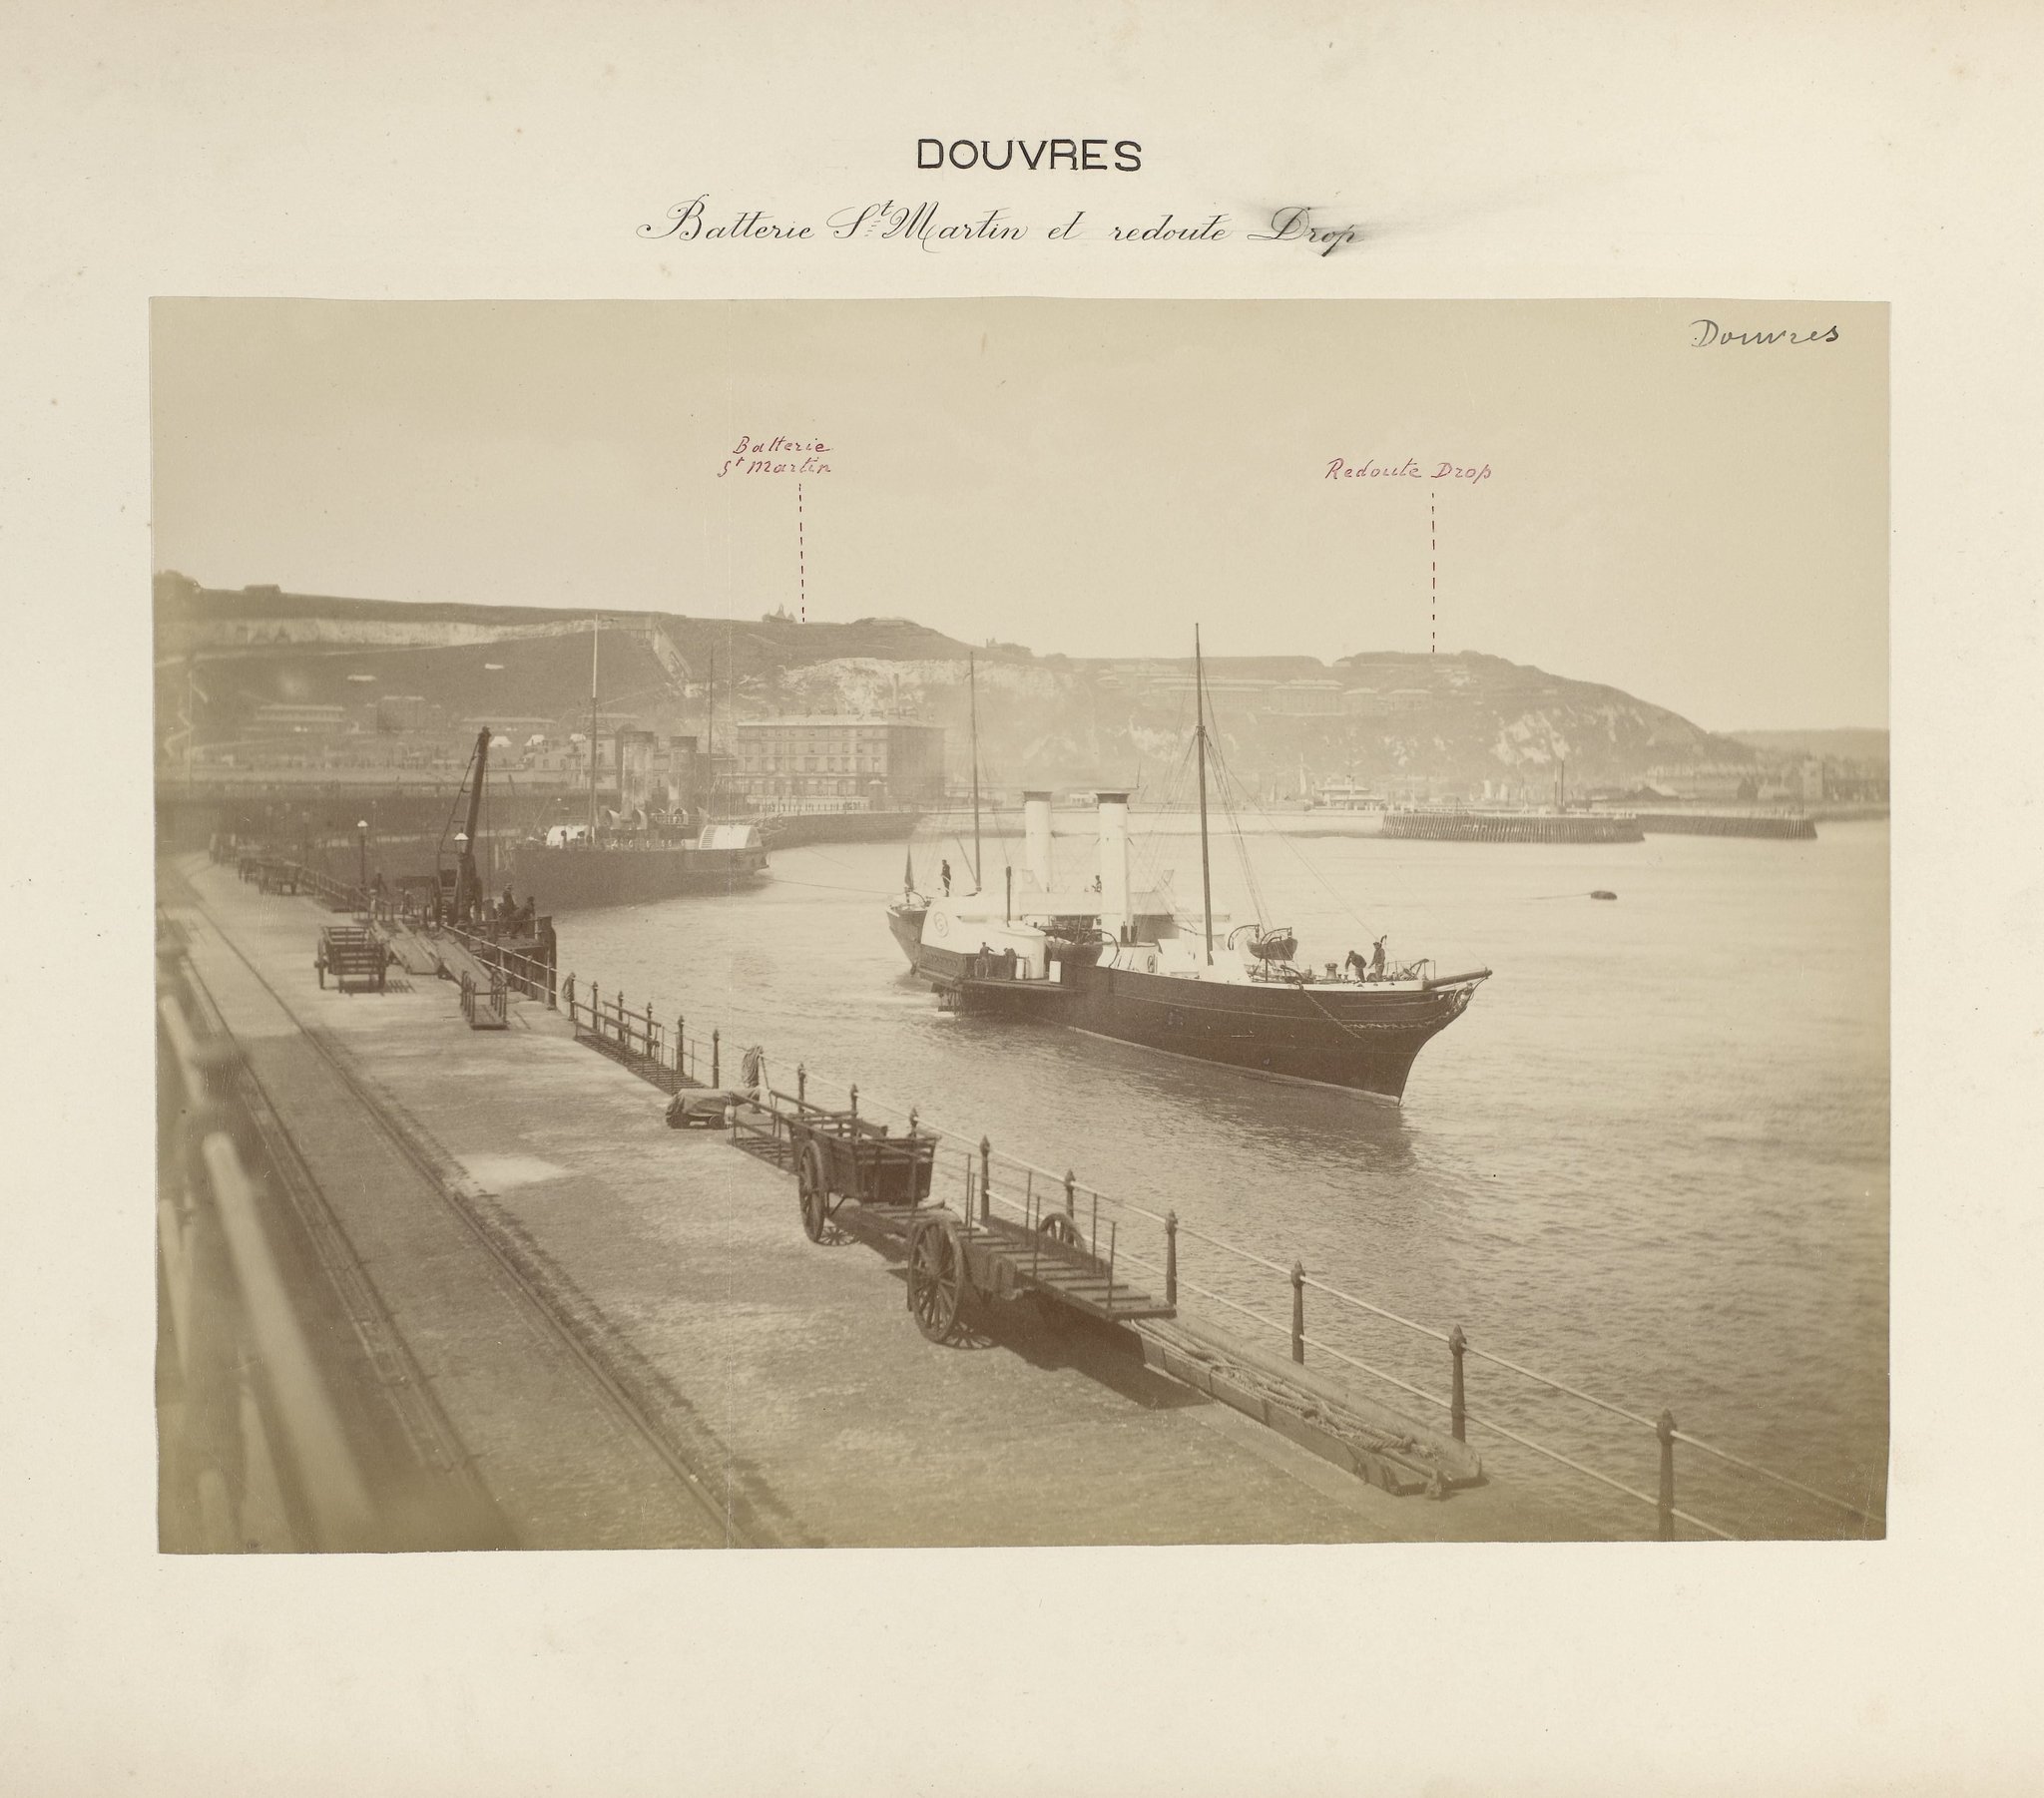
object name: photograph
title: Gezicht op Dover, gezien vanaf de pier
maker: Anonymous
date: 1891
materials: cardboard, paper, photographic support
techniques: albumen print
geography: great britain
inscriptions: inscription: ‘DOUVRES / Batterie St Martin et redoute Drop’, inscription: ‘Douvres’, annotation: ‘Batterie St Martin // Redoute Drop’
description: Foto uit een album met 35 topografische foto's van Britse kustplaatsen, waarop in pen militaire verdedigingswerken zijn aangegeven door een Franse militair.